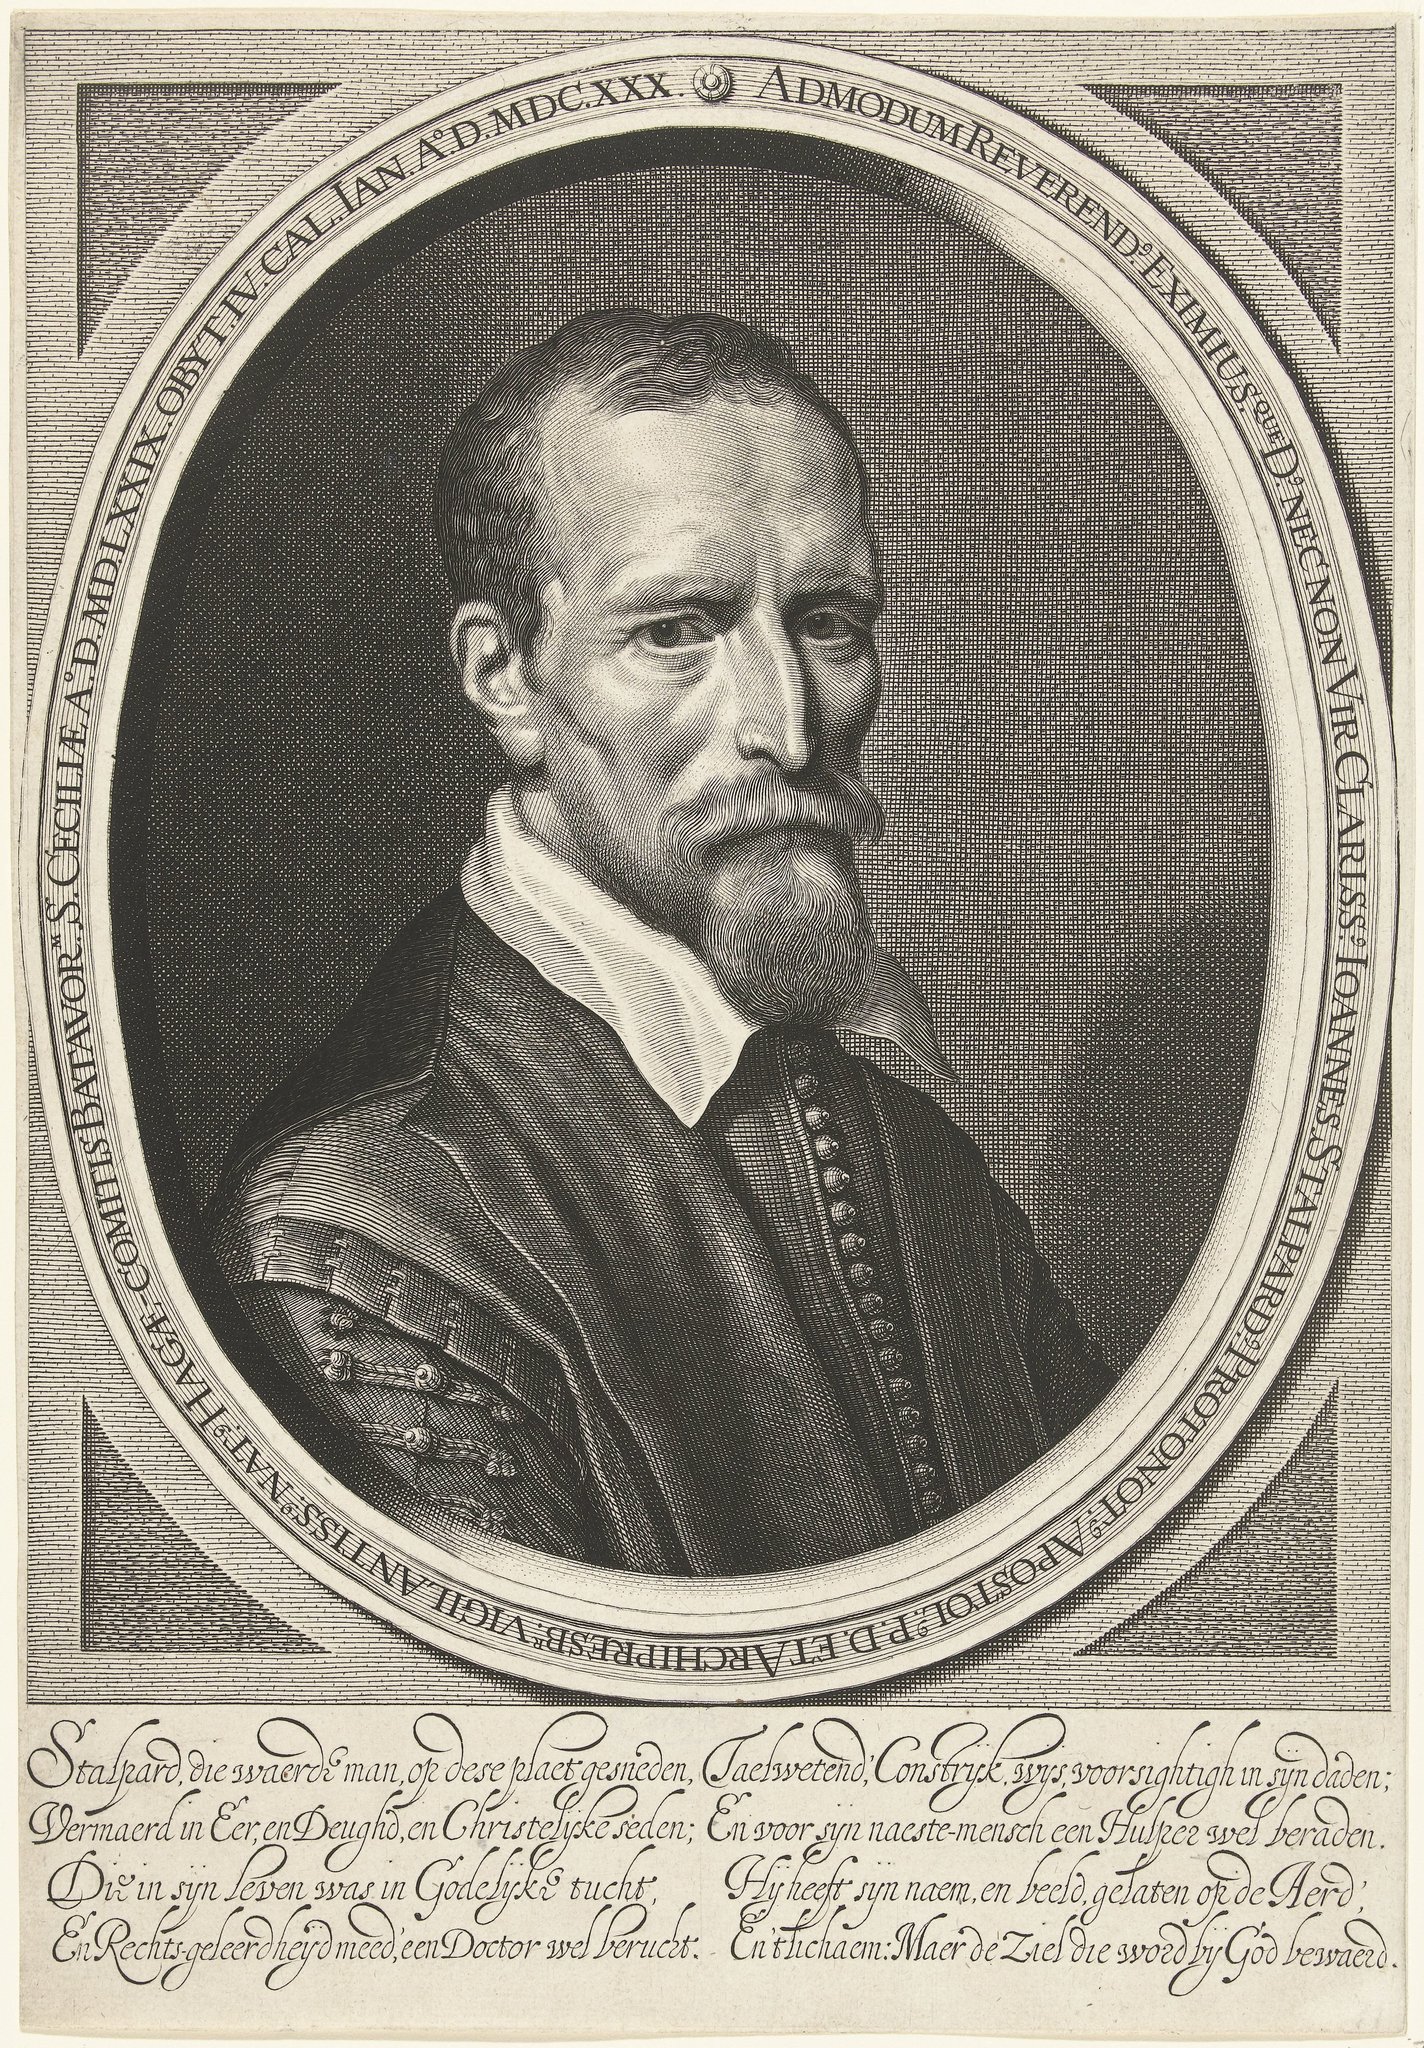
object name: print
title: Portret van Johannes Stalpaert van der Wiele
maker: willem jacobsz delff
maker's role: draughtsman, print maker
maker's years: 1580-1638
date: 1630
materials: paper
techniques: engraving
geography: delft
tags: advocaat, dichter, prior, johannes stalpaert van der wiele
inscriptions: collector's mark: Lugt 2228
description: Portret van Johannes Stalpaert van der Wiele, borststuk in sobere kleding in ovale omlijsting met Latijns opschrift. In ondermarge Nederlands vers in twee coupletten van vier regels.